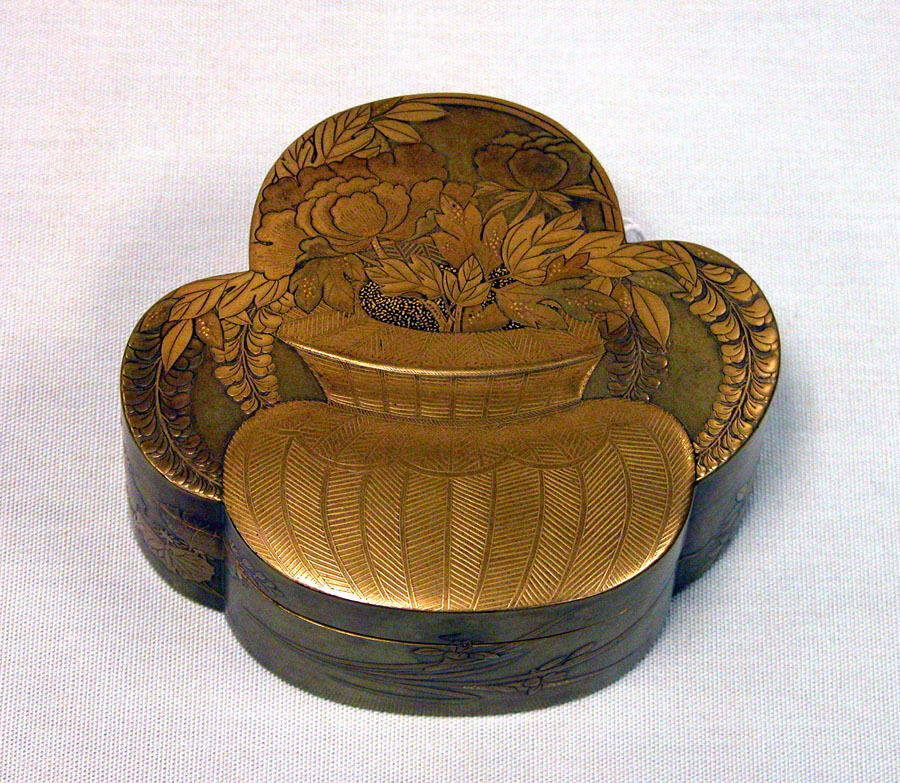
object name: kobako with cover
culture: japanese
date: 1601-1700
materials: gold, lacquer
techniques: maki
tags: flowers